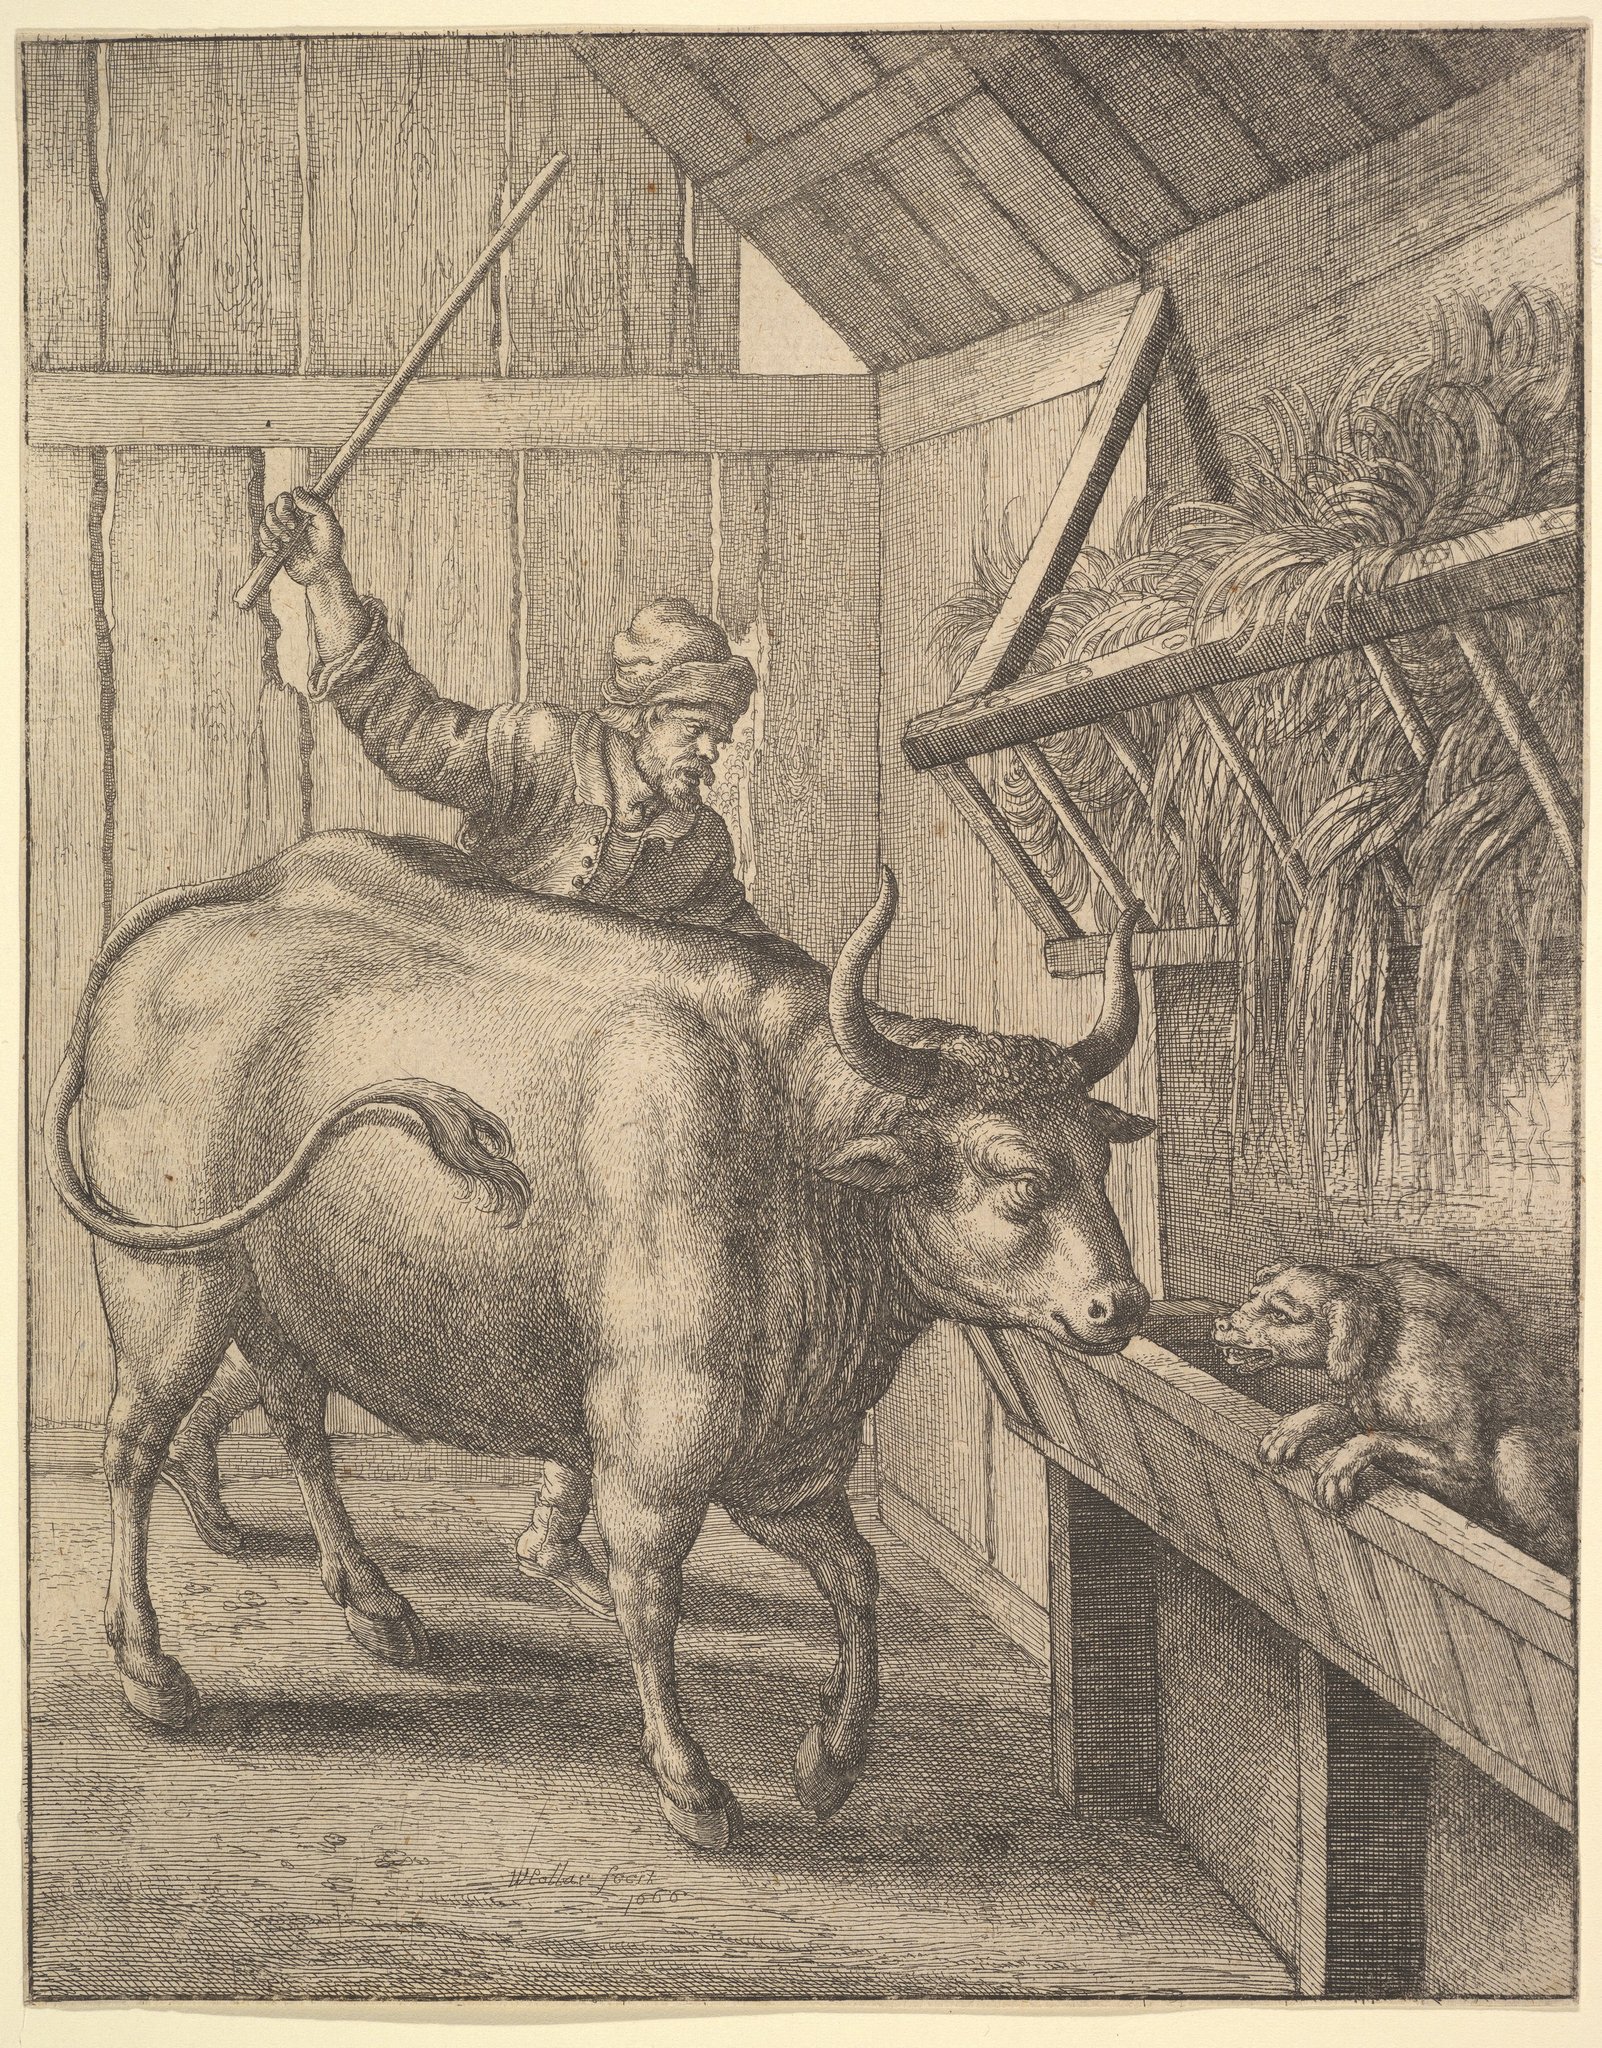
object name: print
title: The Dog in the Manger (from John Ogilby, "Aesopics or a Second Colllection of Fables," 1668)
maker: wenceslaus hollar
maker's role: artist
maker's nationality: bohemian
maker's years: 1607-1677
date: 1666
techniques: etching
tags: animals,men,dogs